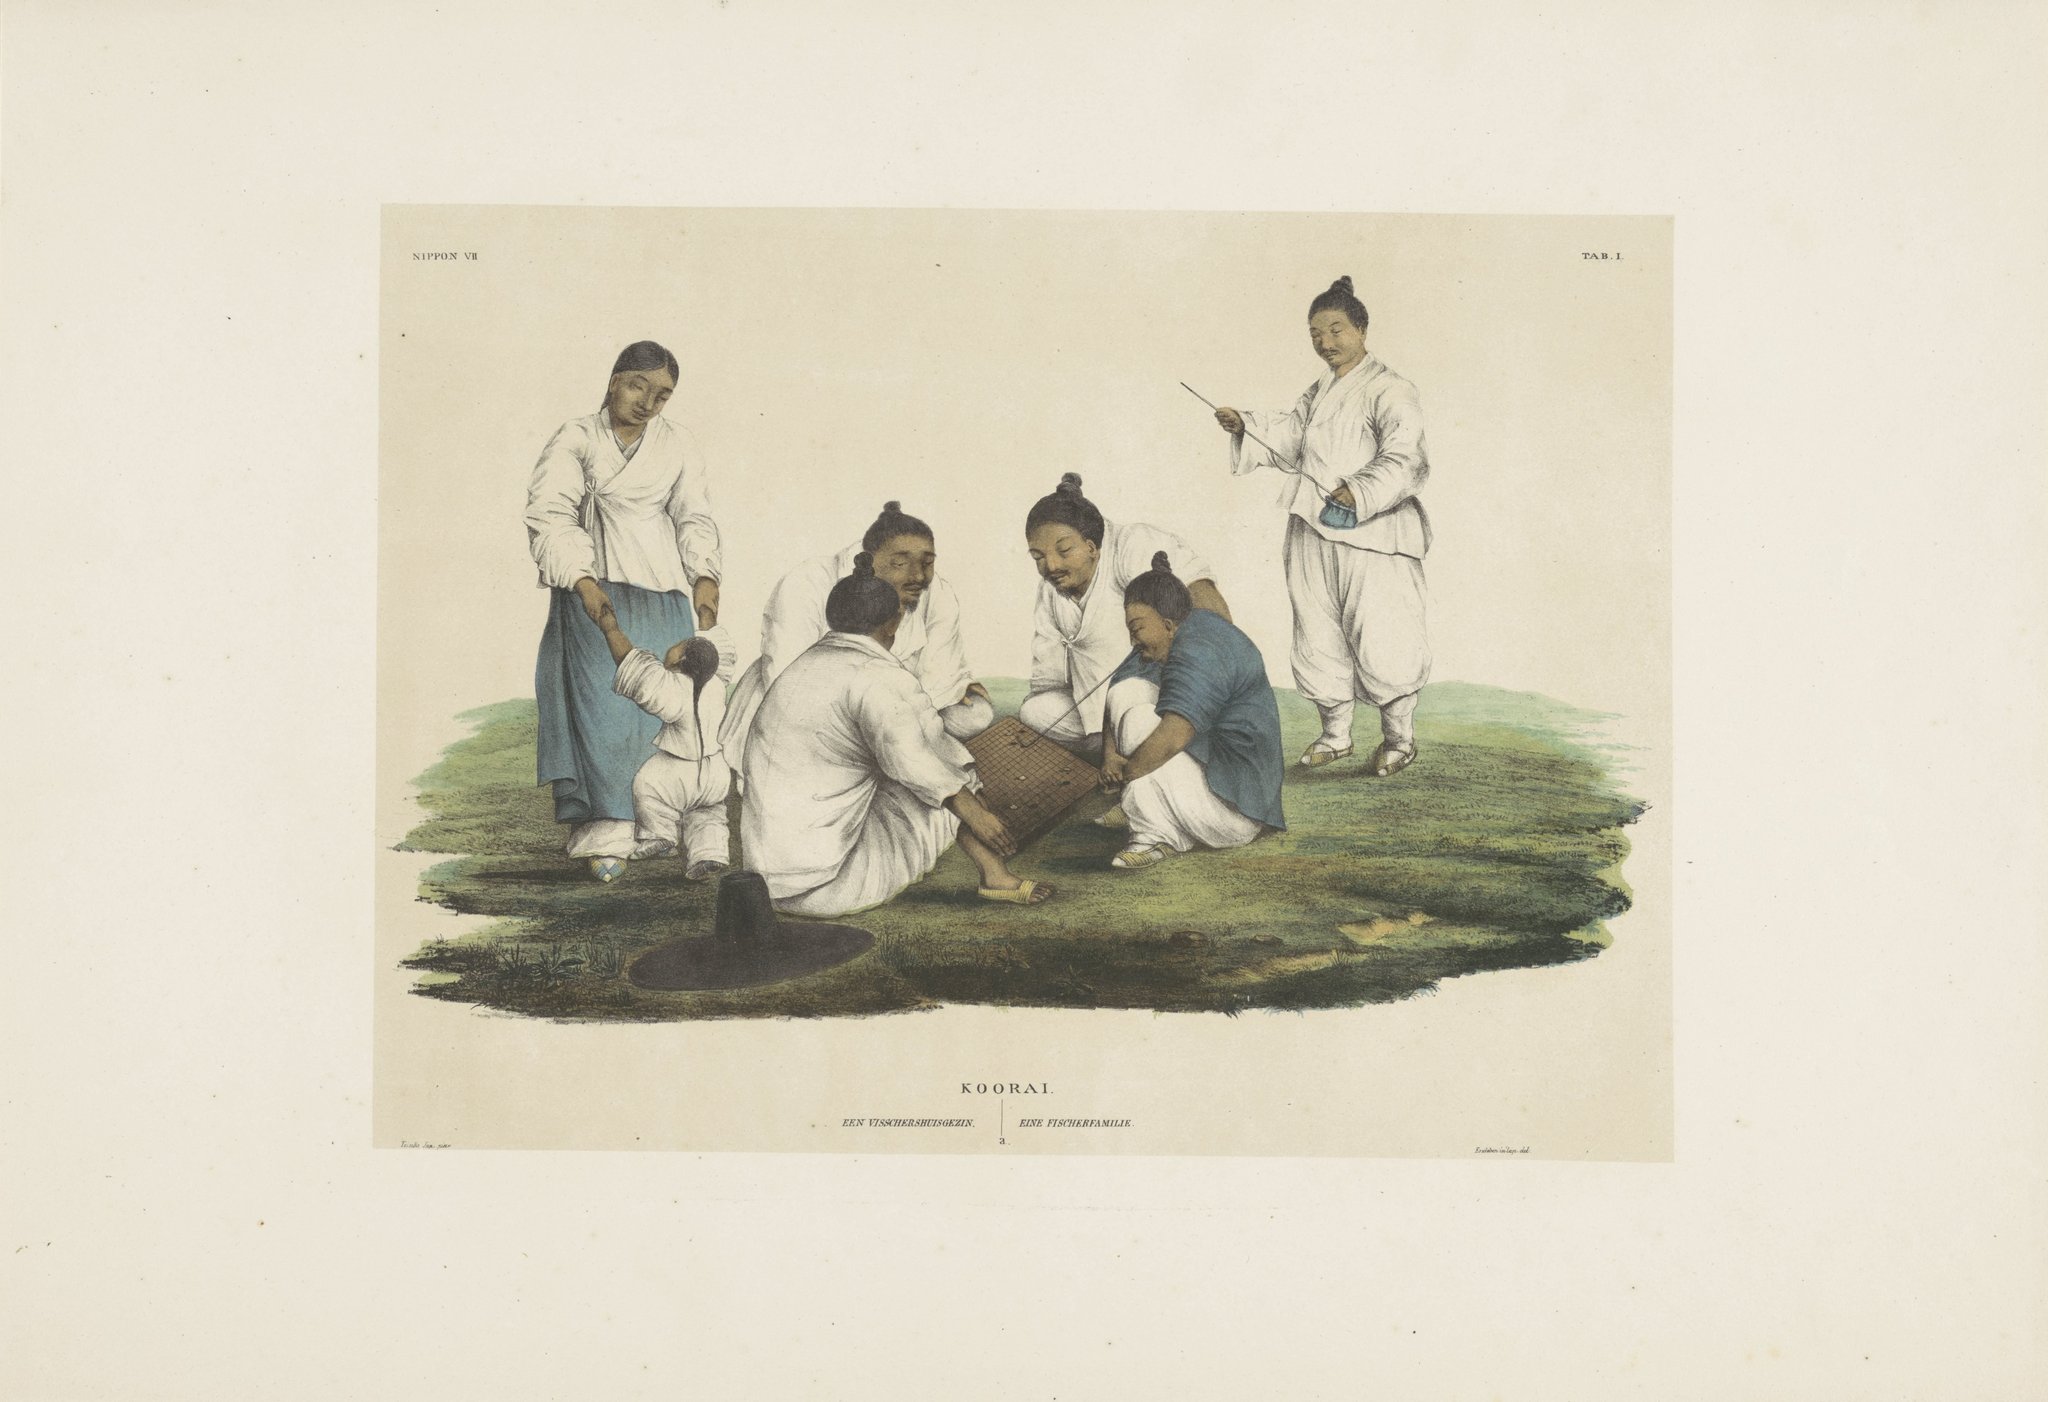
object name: print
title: Koreanen bezig met een spel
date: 1832-1852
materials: paper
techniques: hand coloring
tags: asiatic races and peoples, board-games (+ out of doors (sports, games, etc.))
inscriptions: collector's mark: Lugt 2760, collector's mark: Lugt 2166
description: Vier Koreaanse mannen zitten op de grond rondom een bordspel. Links staat een vrouw met een klein kind, rechts staat een man met een buidel en een stok. In de voorgrond ligt een zwarte hoed op de grond. De prent is genummerd linksboven: Nippon VII en rechtsboven: TAB. I.